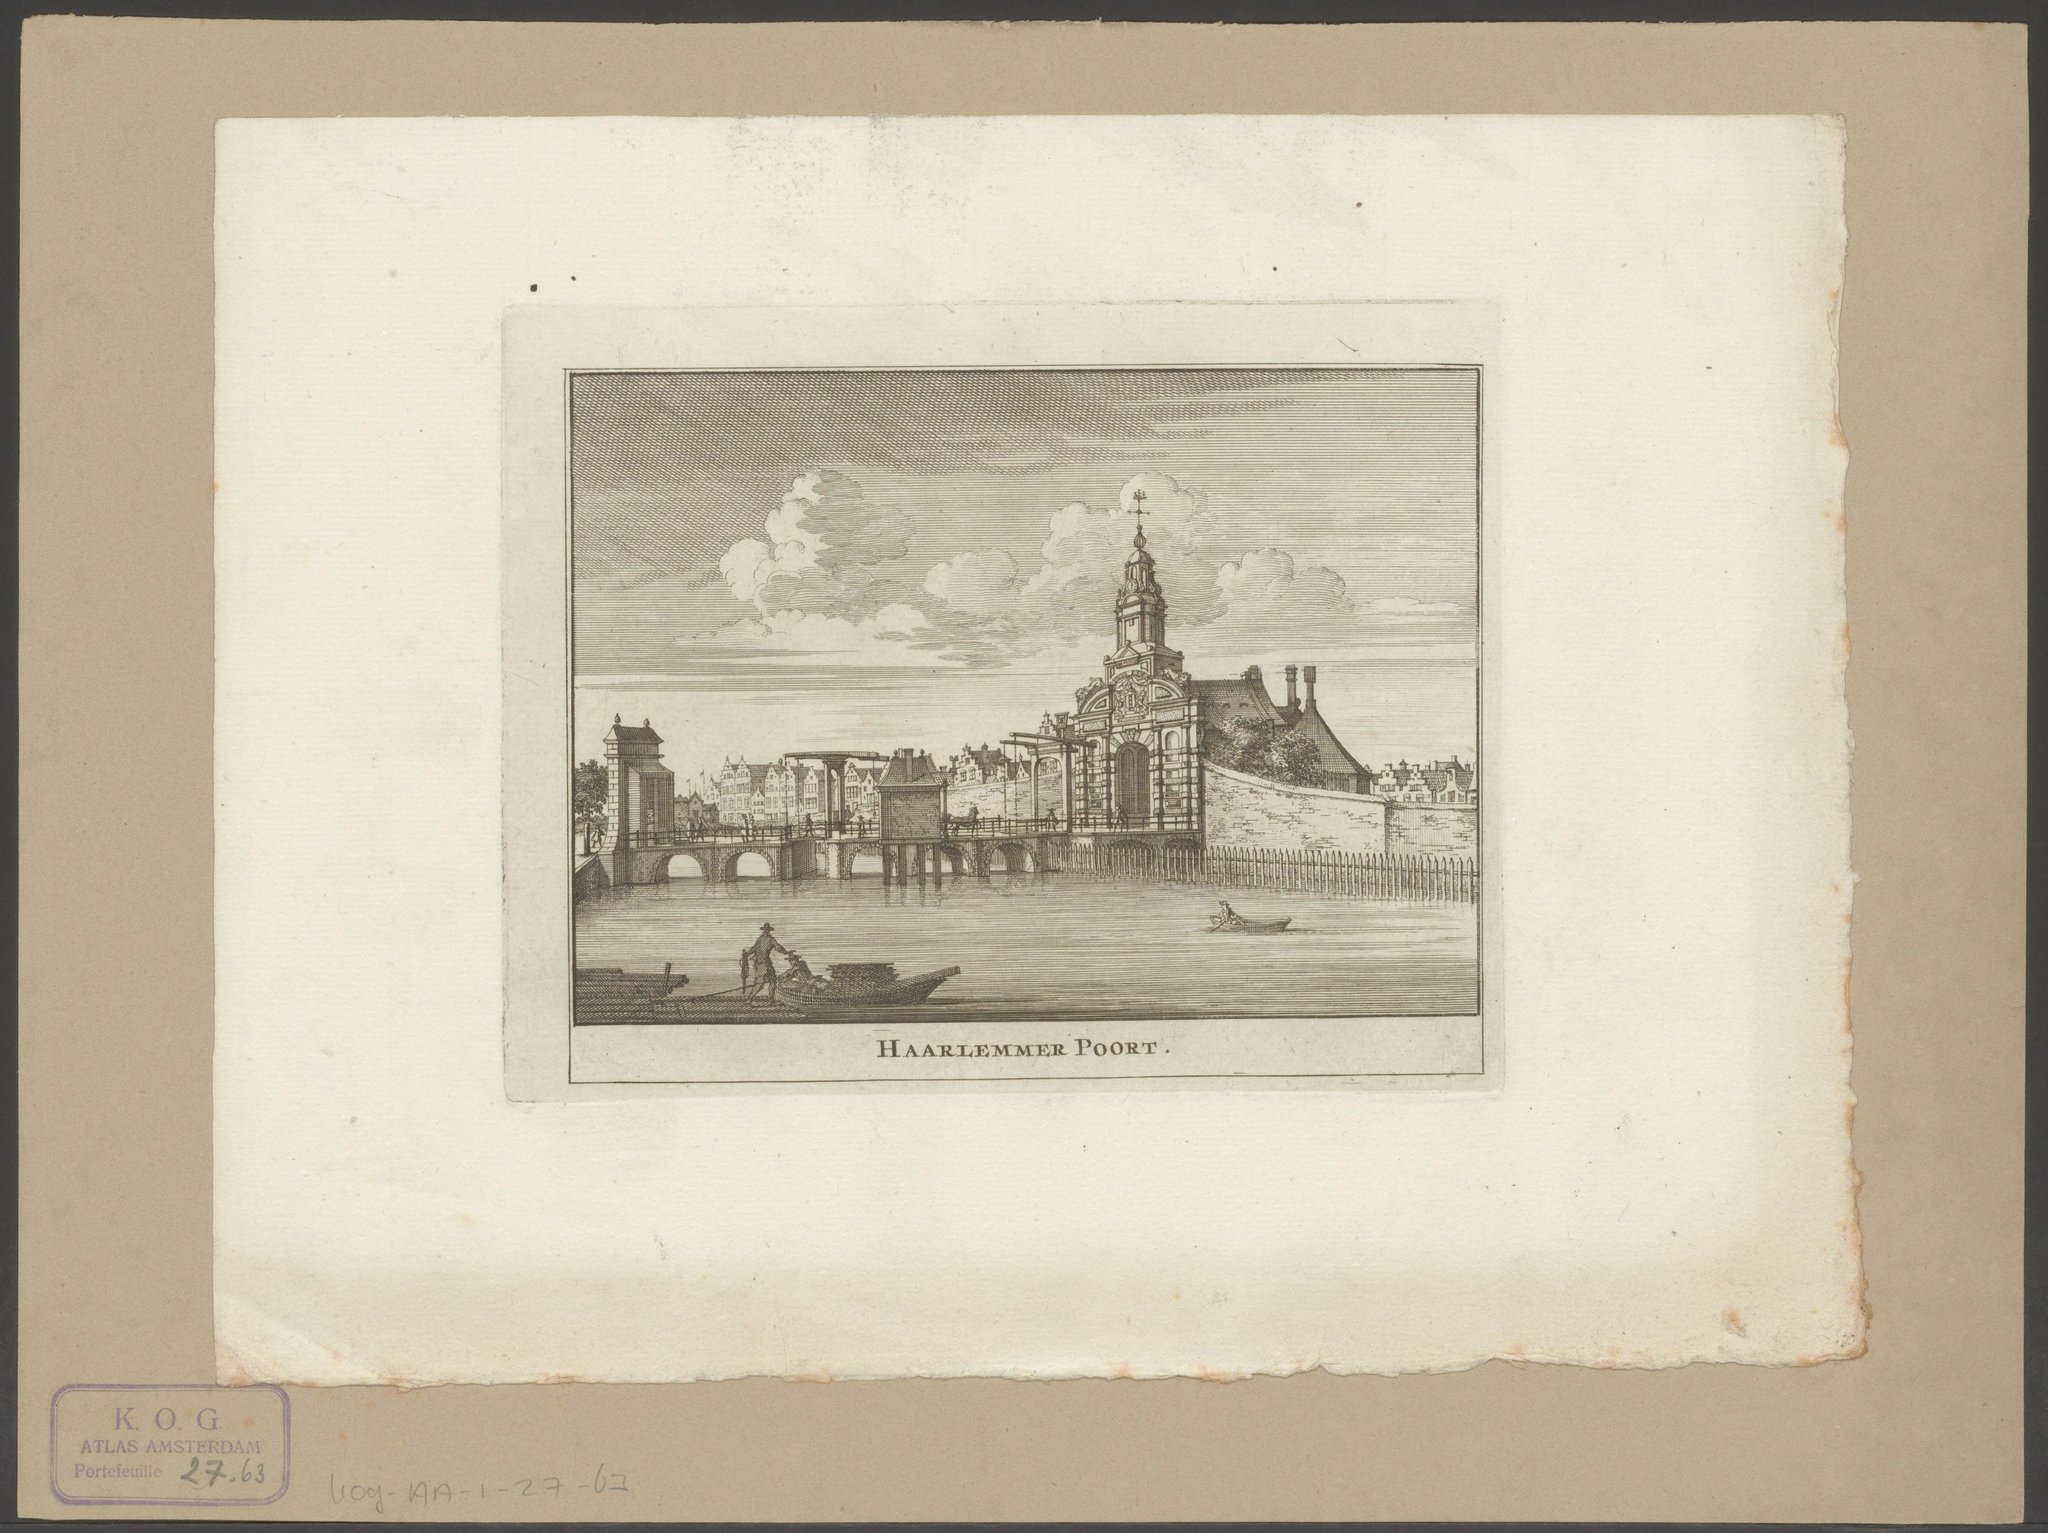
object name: print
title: Gezicht op de Vierde Haarlemmerpoort in Amsterdam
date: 1726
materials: paper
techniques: engraving, etching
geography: amsterdam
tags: rowing-boat, canoe, etc., bridge in city across river, canal, etc., city-gate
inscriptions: collector's mark: Lugt 1641b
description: Prent uit: Hoorn, Nicolaas ten. Wegwyzer door Amsterdam, Zynde eene beknopte verhandeling van desselfs eerste opkomst, vergrootingen, en teegenwoordigen staat (…). 2de druk. Amsterdam: Nicolaas ten Hoorn, 1726, p. 288-289. En in de latere edities (Amsterdam: erven J. Ratelband & Co, 1737, en Amsterdam: Pieter Meyer, 1751). In de eerste editie heeft deze prent een andere plek in het boek, en een ander nummer.